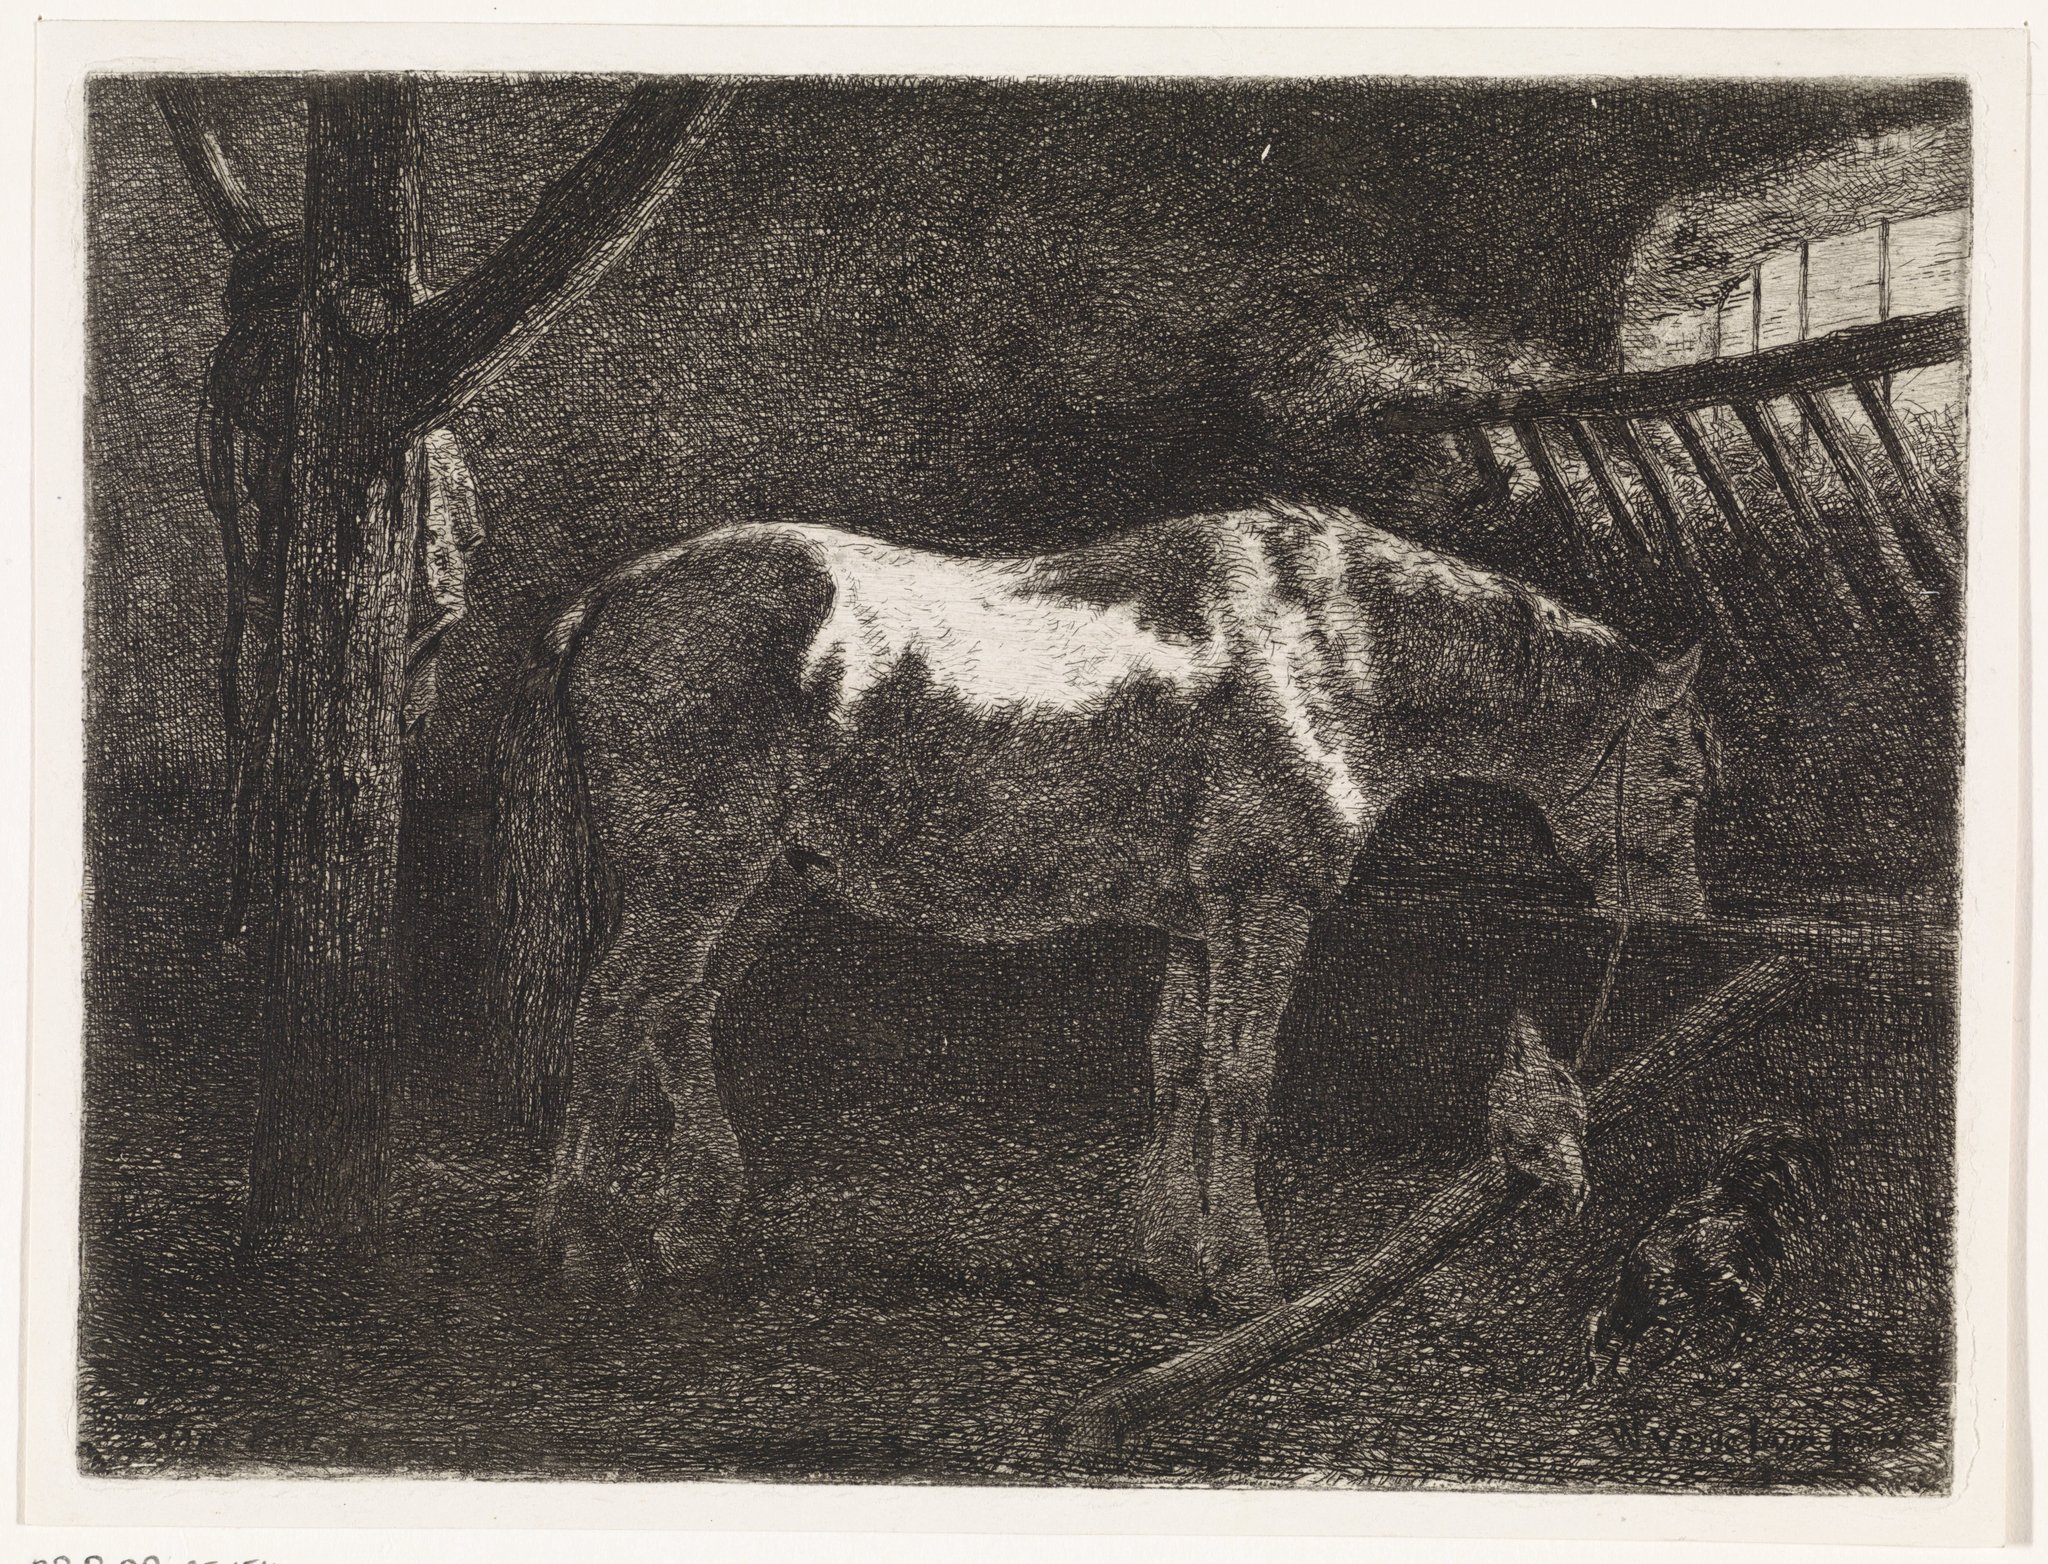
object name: print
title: Paard in stal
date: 1860-1894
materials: paper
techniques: etching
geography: the hague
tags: horses and kindred animals, fowl (cock, hen, chicken, etc.), stall, stable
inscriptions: collector's mark: Lugt 2228